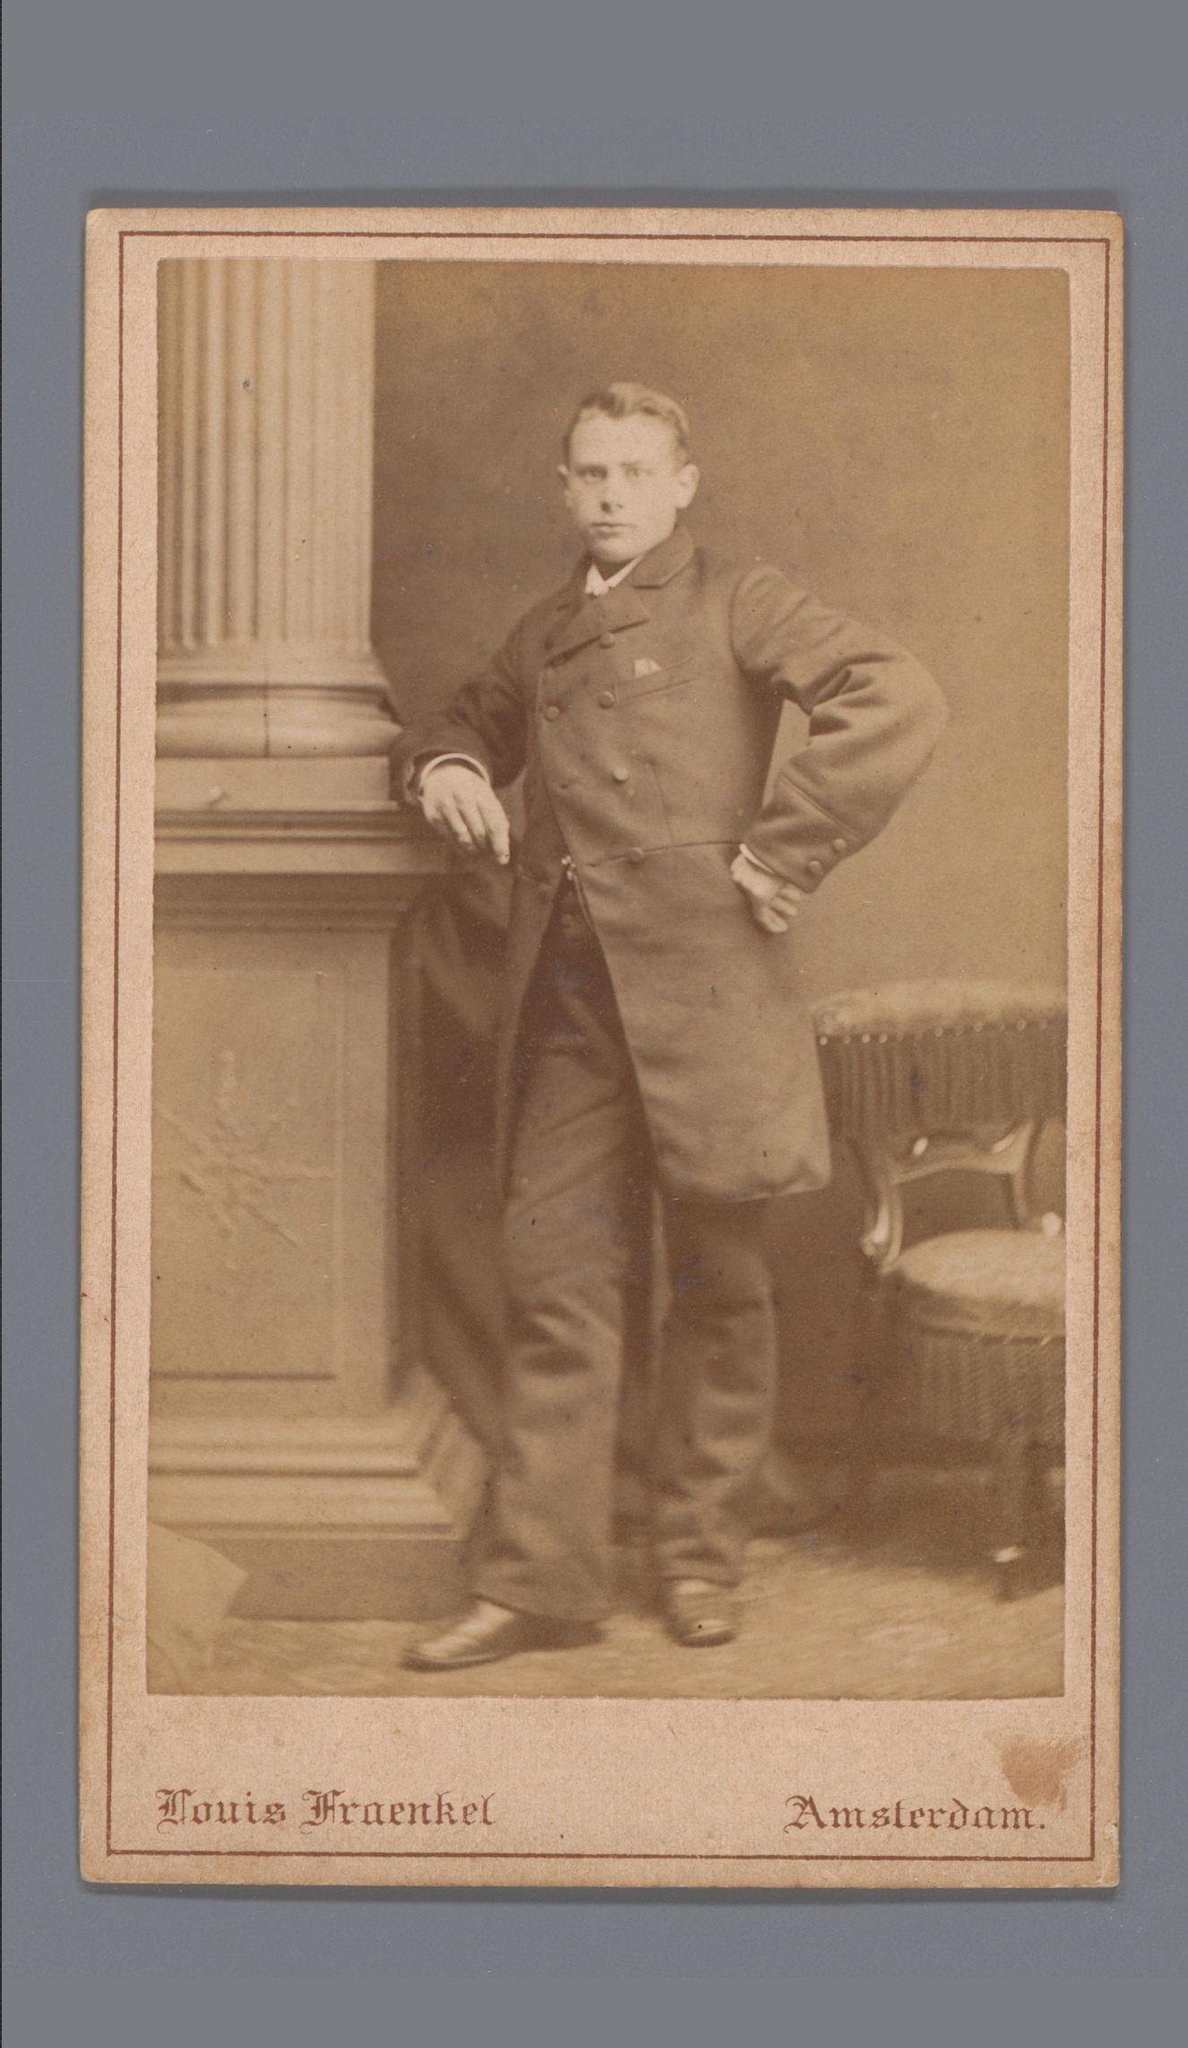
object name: photograph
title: Portret van een onbekende man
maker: louis fraenkel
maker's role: fotograaf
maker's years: 1842-1929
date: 1878-1886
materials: cardboard, paper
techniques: albumen print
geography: amsterdam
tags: adult man, anonymous historical person portrayed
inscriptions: address: ‘70. Leidsche Straat 70/ by de Kerkstraat/ AMSTERDAM.’, inscription: ‘Portretten in alle afmetingen Groepen, Architecturen,/ Fabriek & andere Gebouwen./ Kleine portretten worden tot in levensgroote Overgenomen./ Aan bovenstaand Adres kan men van/ deze portretten steeds nabestellen.’